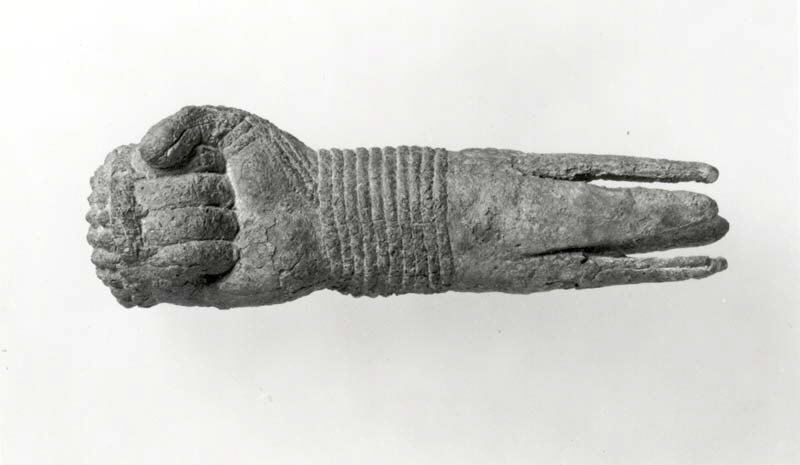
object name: object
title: Object in the form of clenched fist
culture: bactria-margiana archaeological complex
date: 2333-1668 BCE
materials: copper alloy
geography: bactria-margiana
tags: hands